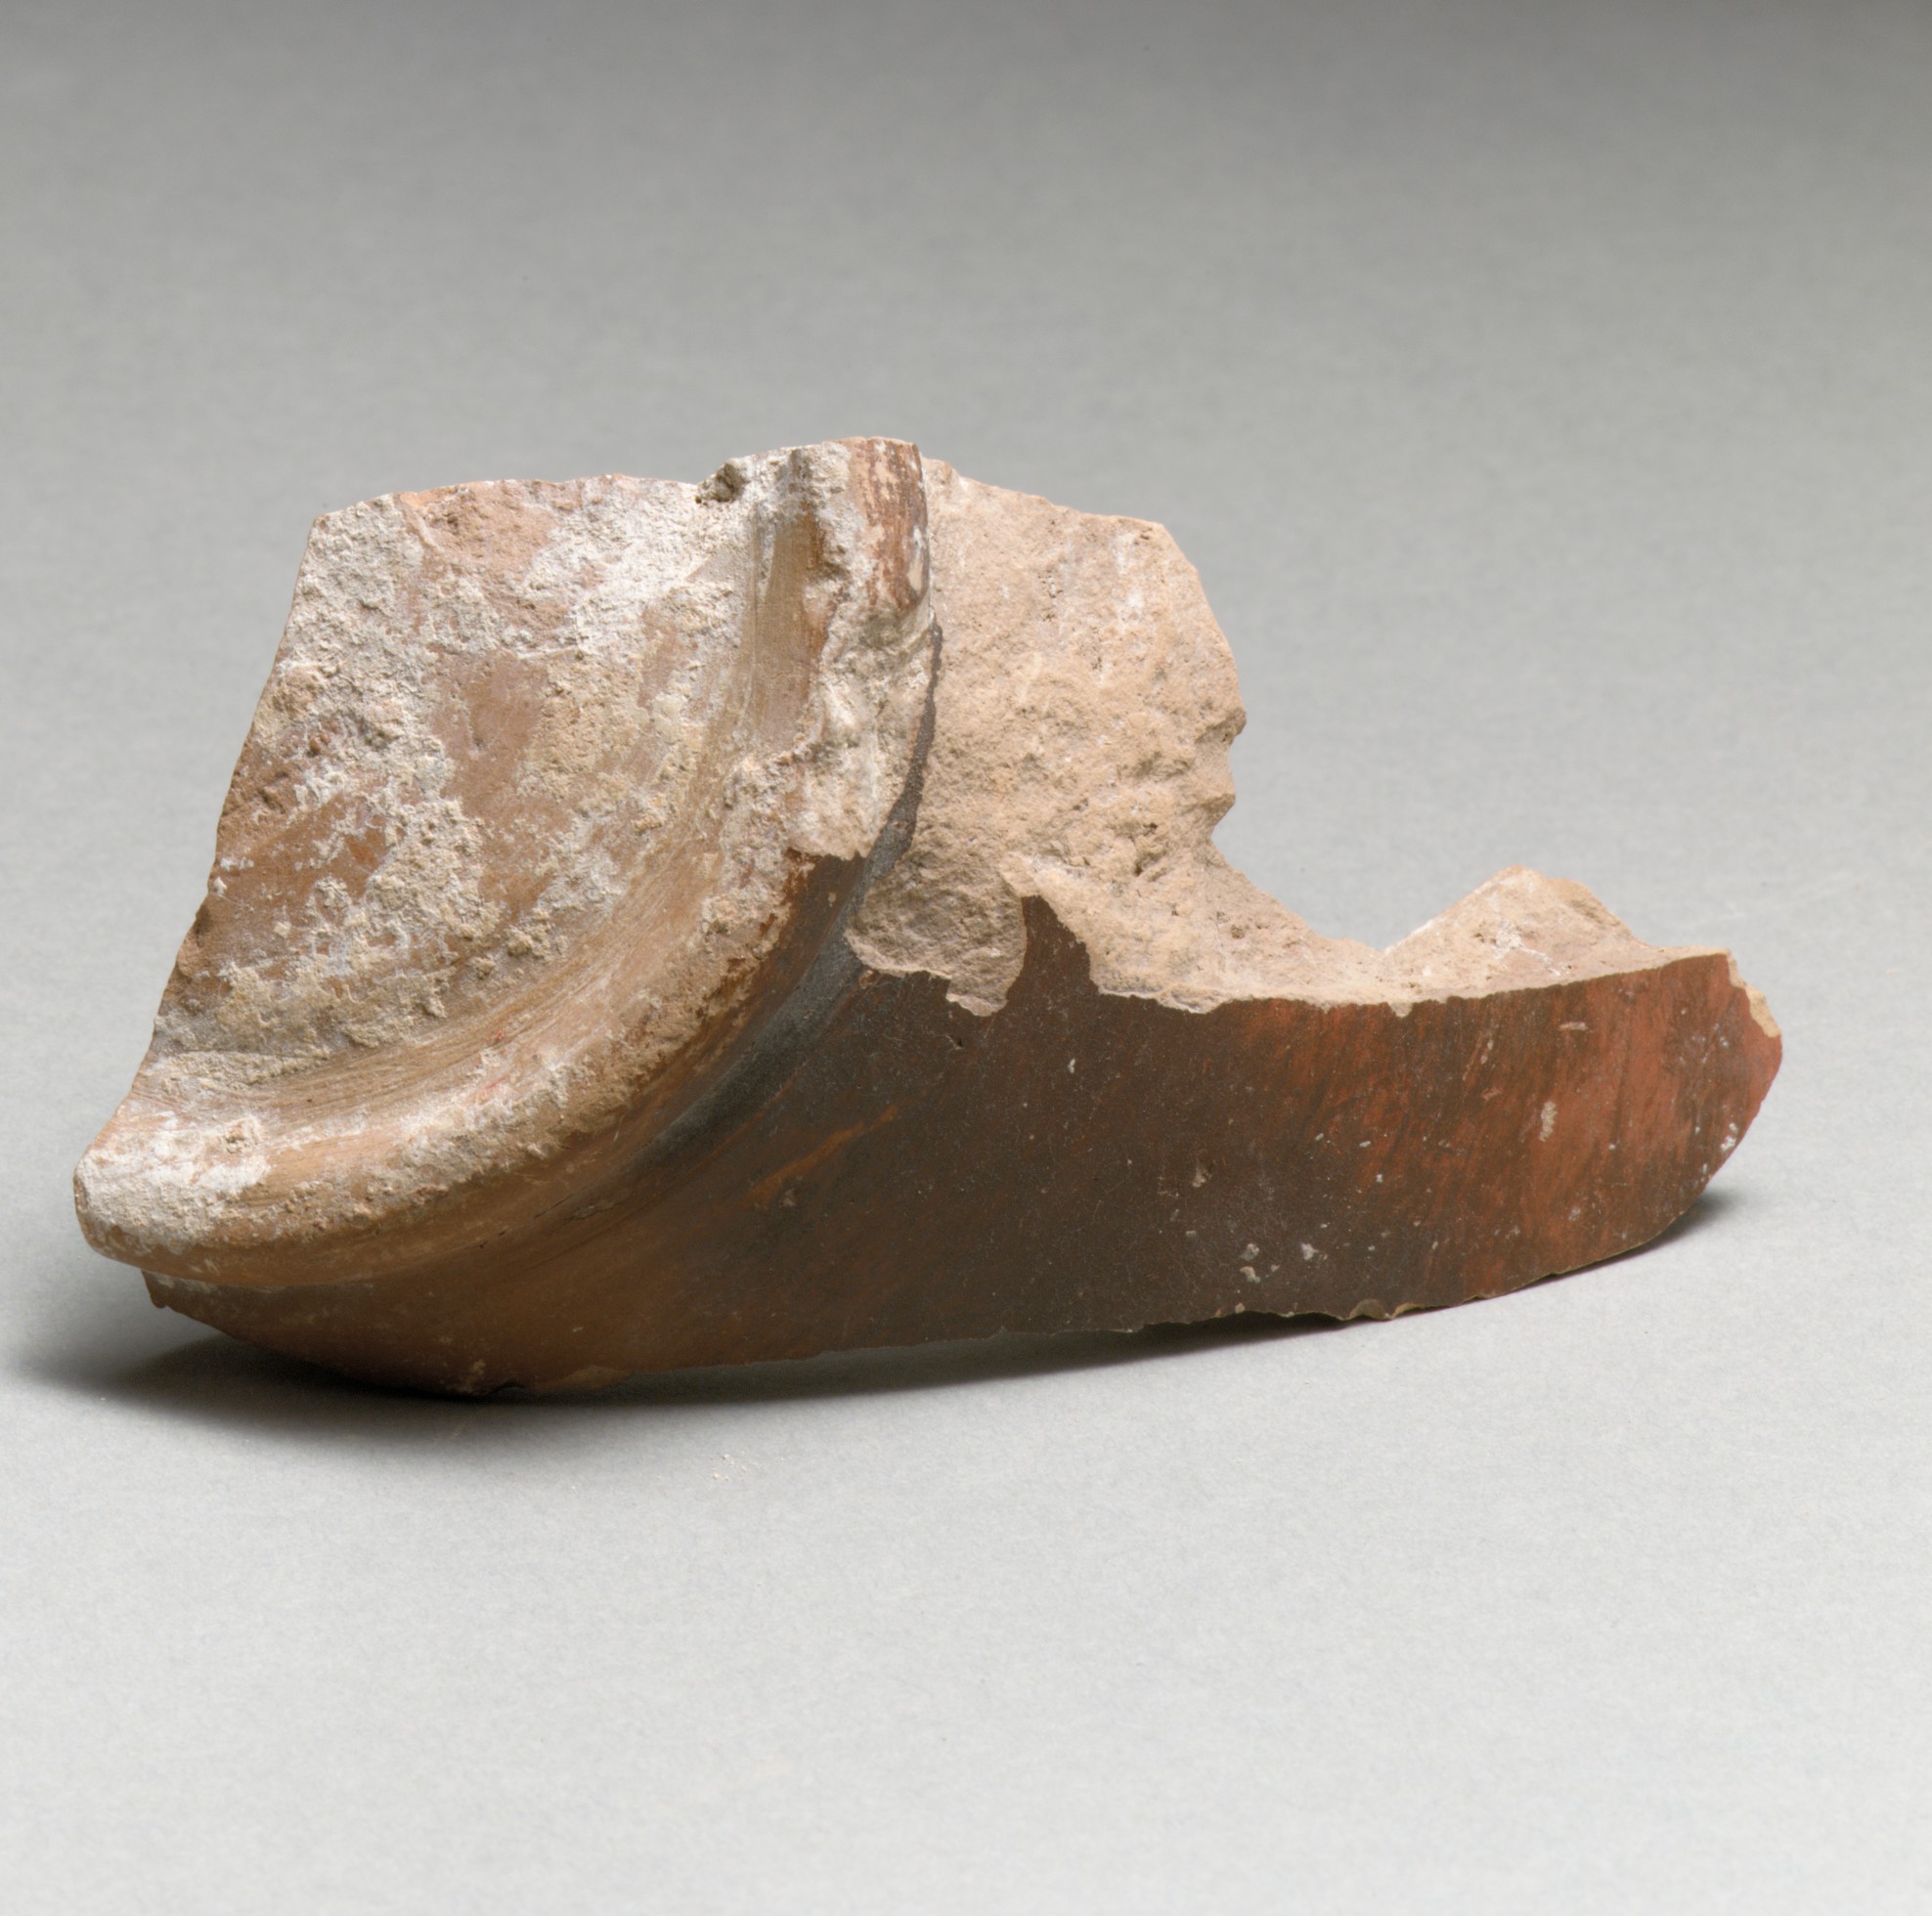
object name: vase fragment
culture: minoan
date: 2600-2000 BCE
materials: terracotta